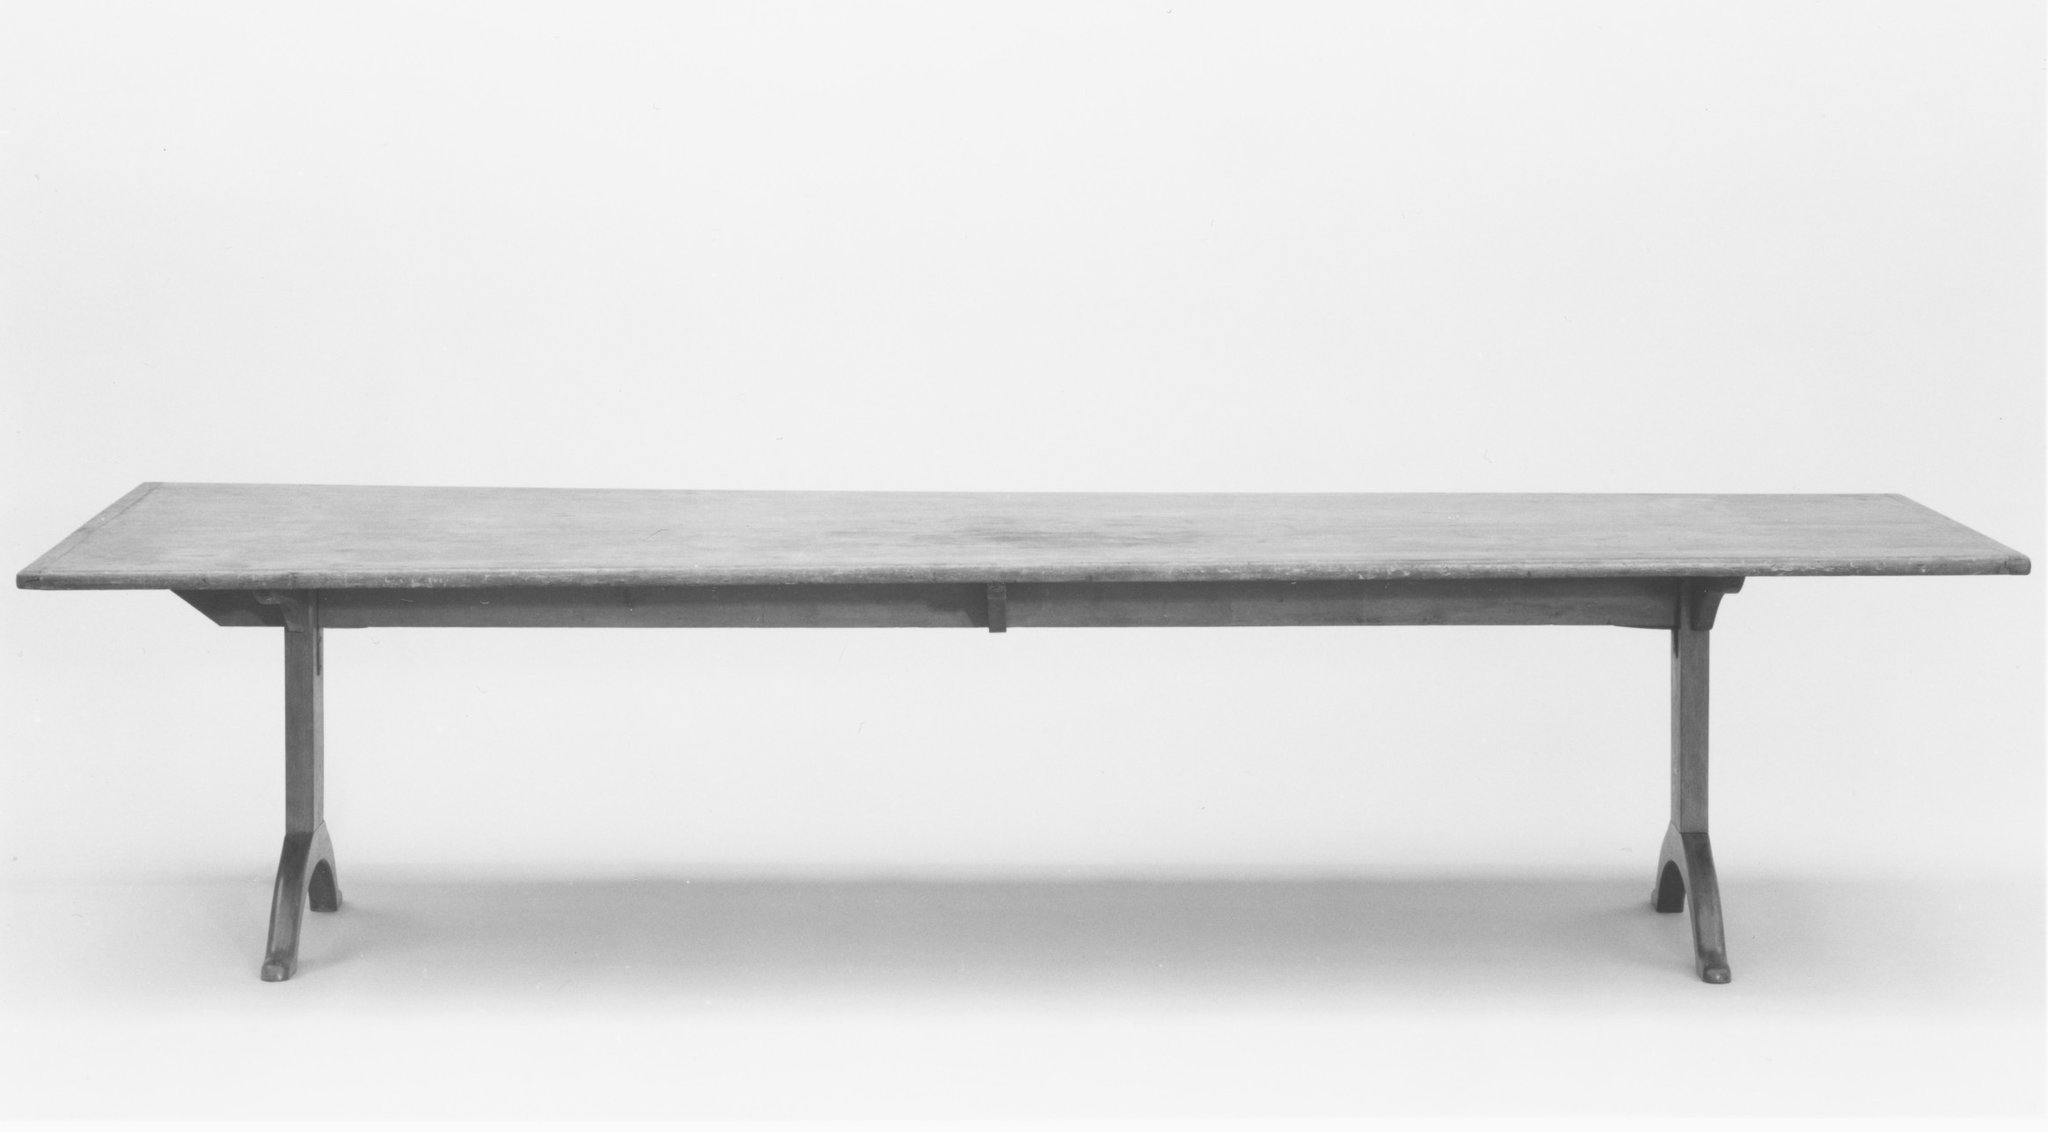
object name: dining table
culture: american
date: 1825-1850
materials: wood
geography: united states